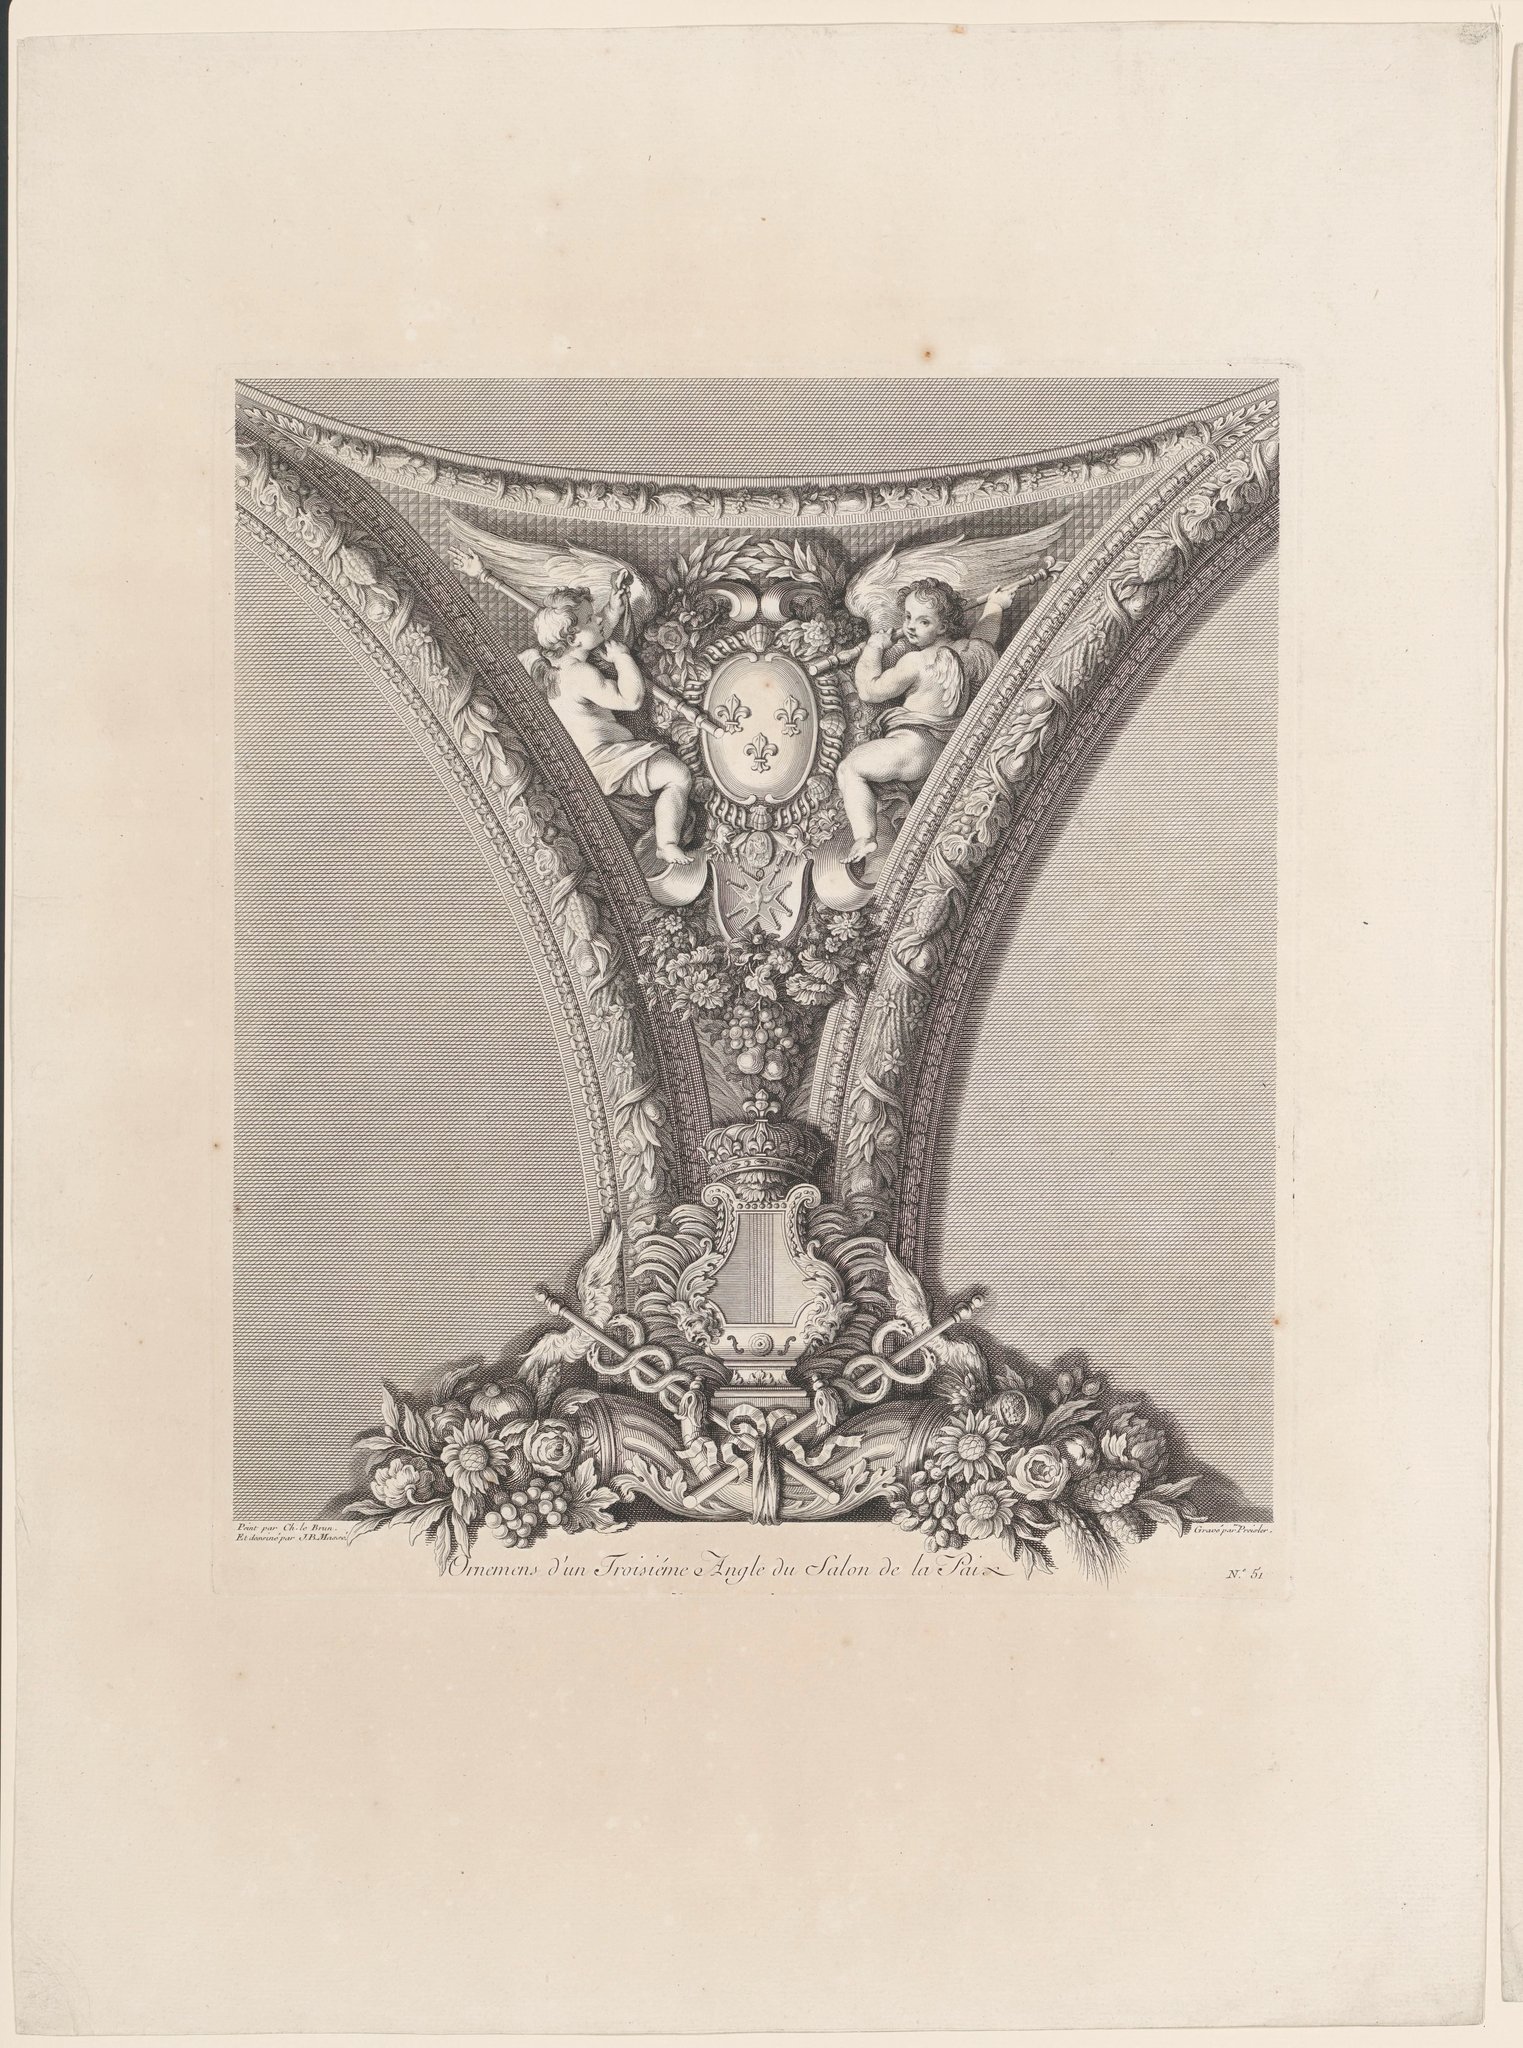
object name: print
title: Ornemens d'un troisiéme angle du salon de la Paix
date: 1752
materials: paper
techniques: engraving, etching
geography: paris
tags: (decorated) ceiling, caduceus (staff with two snakes, attribute of mercury), cupids: 'amores', 'amoretti', 'putti'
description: Prent uit: Massé, Jean Baptiste. La Grande Galerie de Versailles, et les deux salons qui l'accompagnent, peints par Charles le Brun premier peintre de Louis XIV, dessinés par Jean- Baptiste Masse peintre et conseiller de l'Academie royale de peinture & sculpture; et gravés sous ses yeux par les meilleurs maitres du tems. Parijs: Imprimerie Royale, 1752.